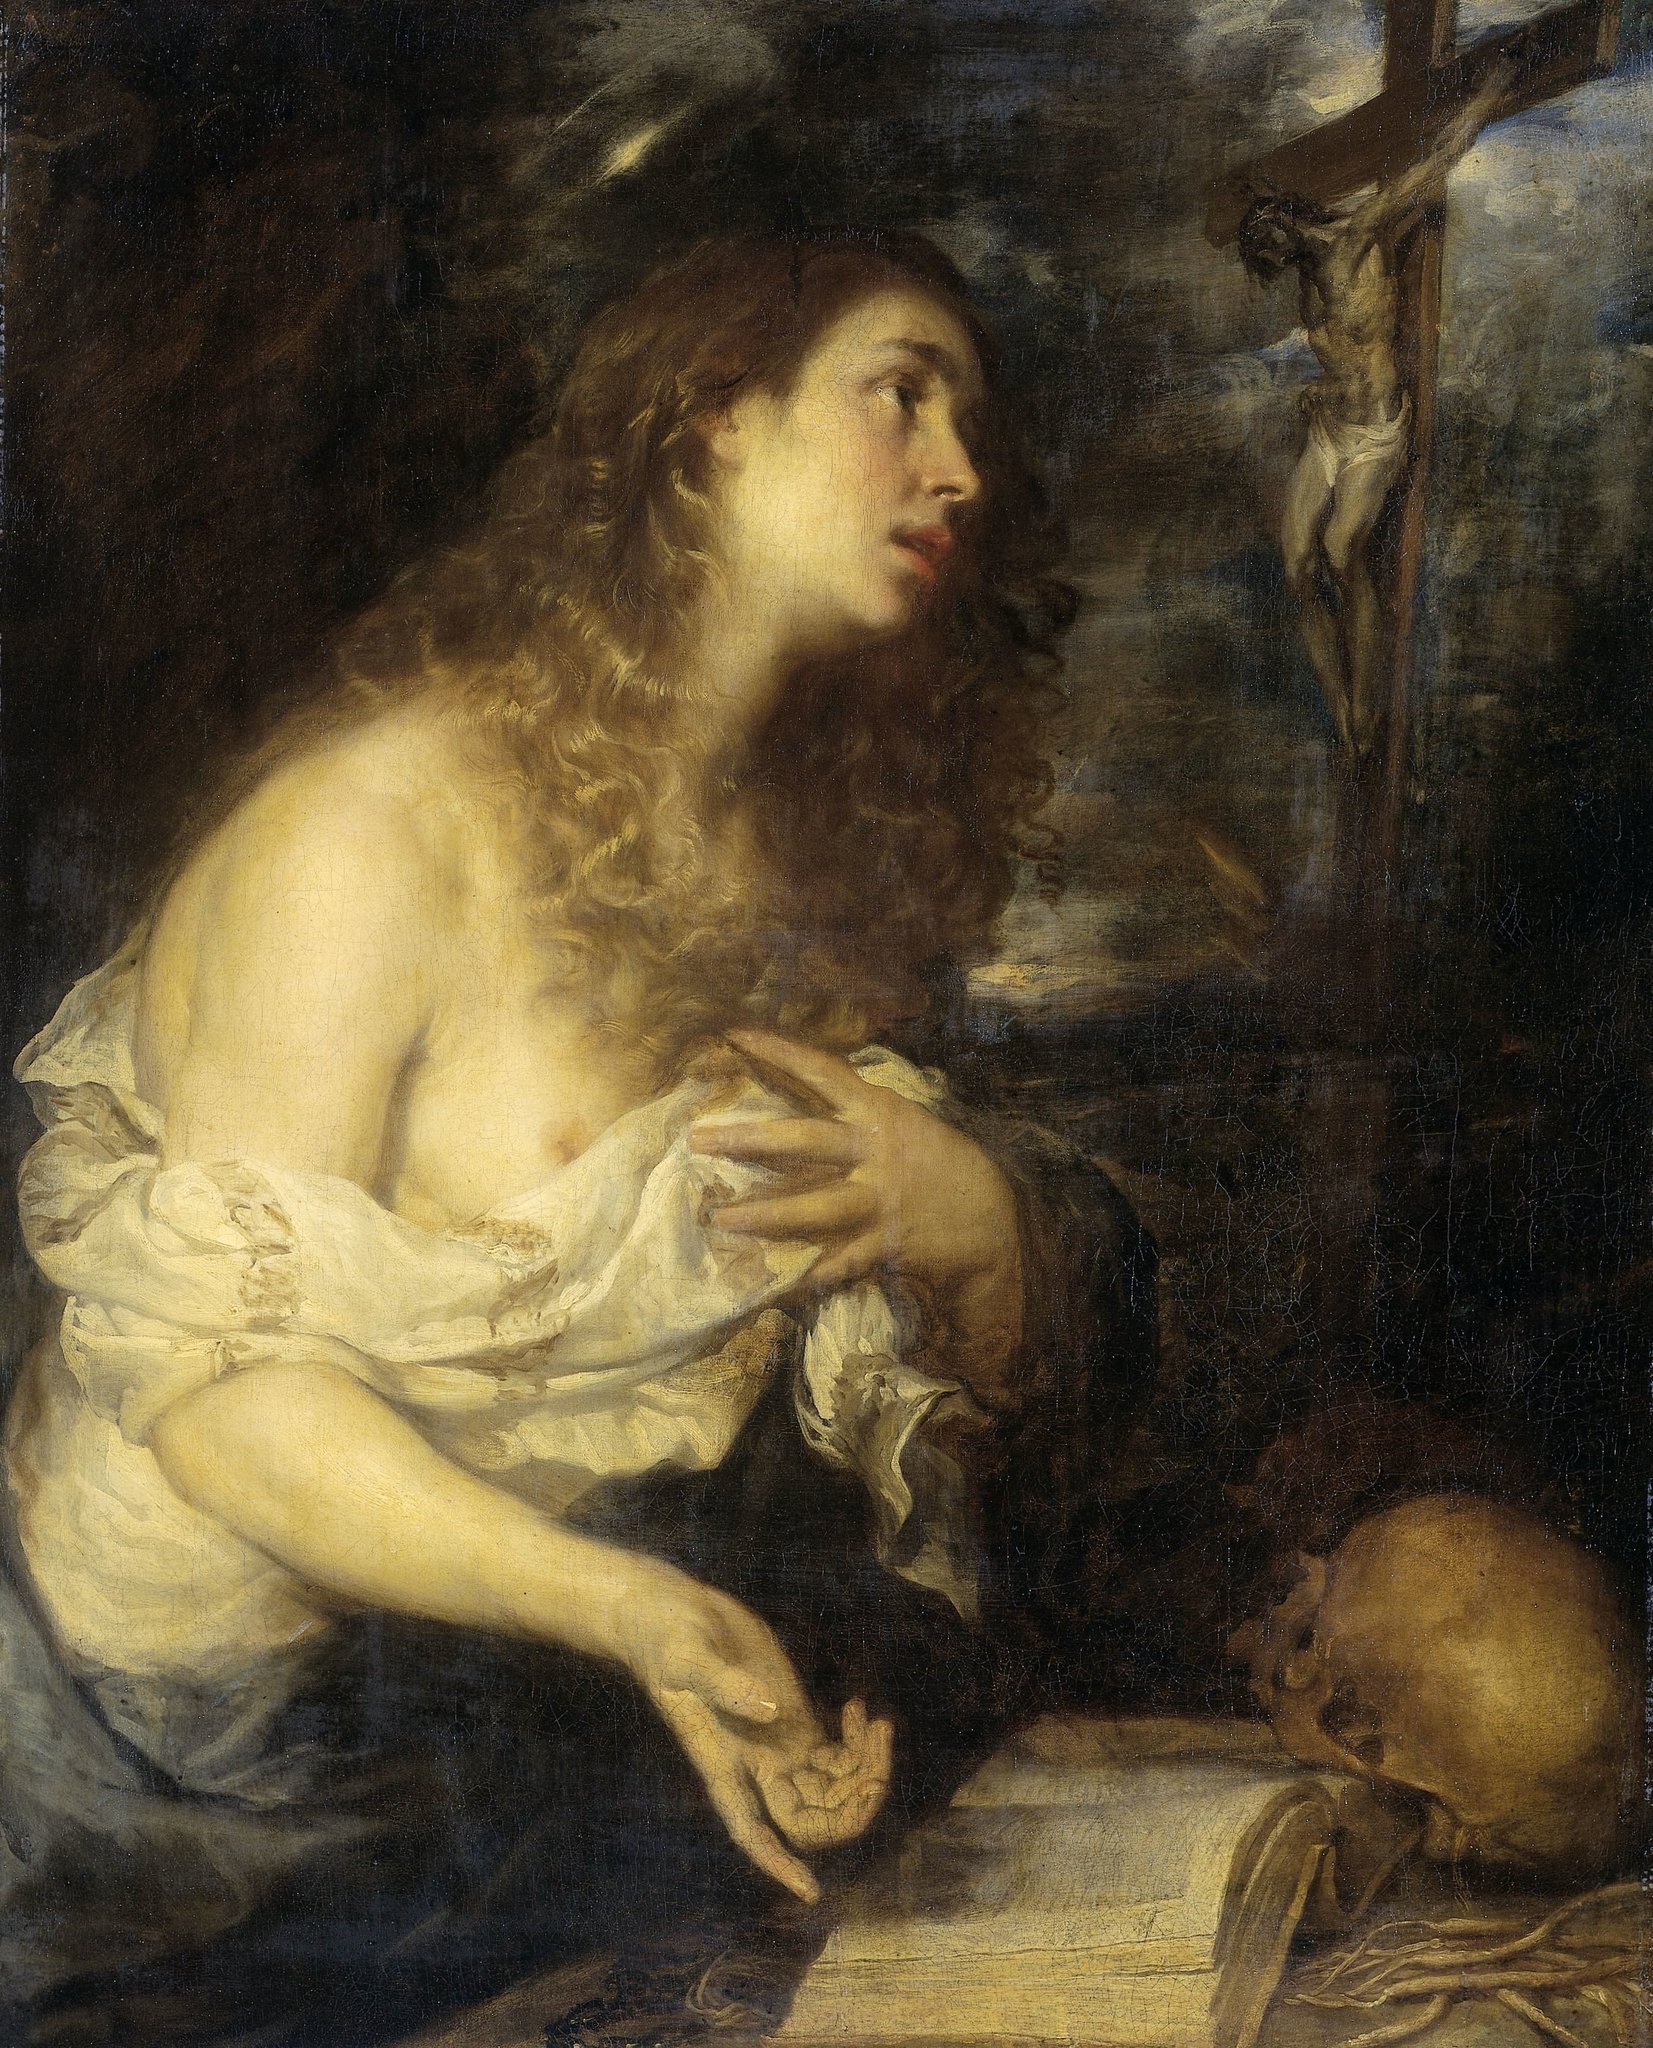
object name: painting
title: The Penitent Mary Magdalene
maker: mateo cerezo (ii)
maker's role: painter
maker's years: 1637-1666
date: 1661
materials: canvas, oil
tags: the penitent st. mary magdalene (often before a cave, possibly at la sainte-baume hill): her long hair covers her (naked) body, she reads, meditates or raises her tear-filled eyes towards heaven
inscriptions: signature and date: ‘Matheo zereço ft. añ de 1661’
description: Mary Magdalene was the most important female follower of Jesus. She was present when he was crucified and the first witness to his resurrection. In the art of painting, she was often portrayed as a voluptuous prostitute, as in this work: she was a sinner who came to see the light. However, the Catholic Church did not fully acknowledge her role as a powerful and spiritual woman until 1969.